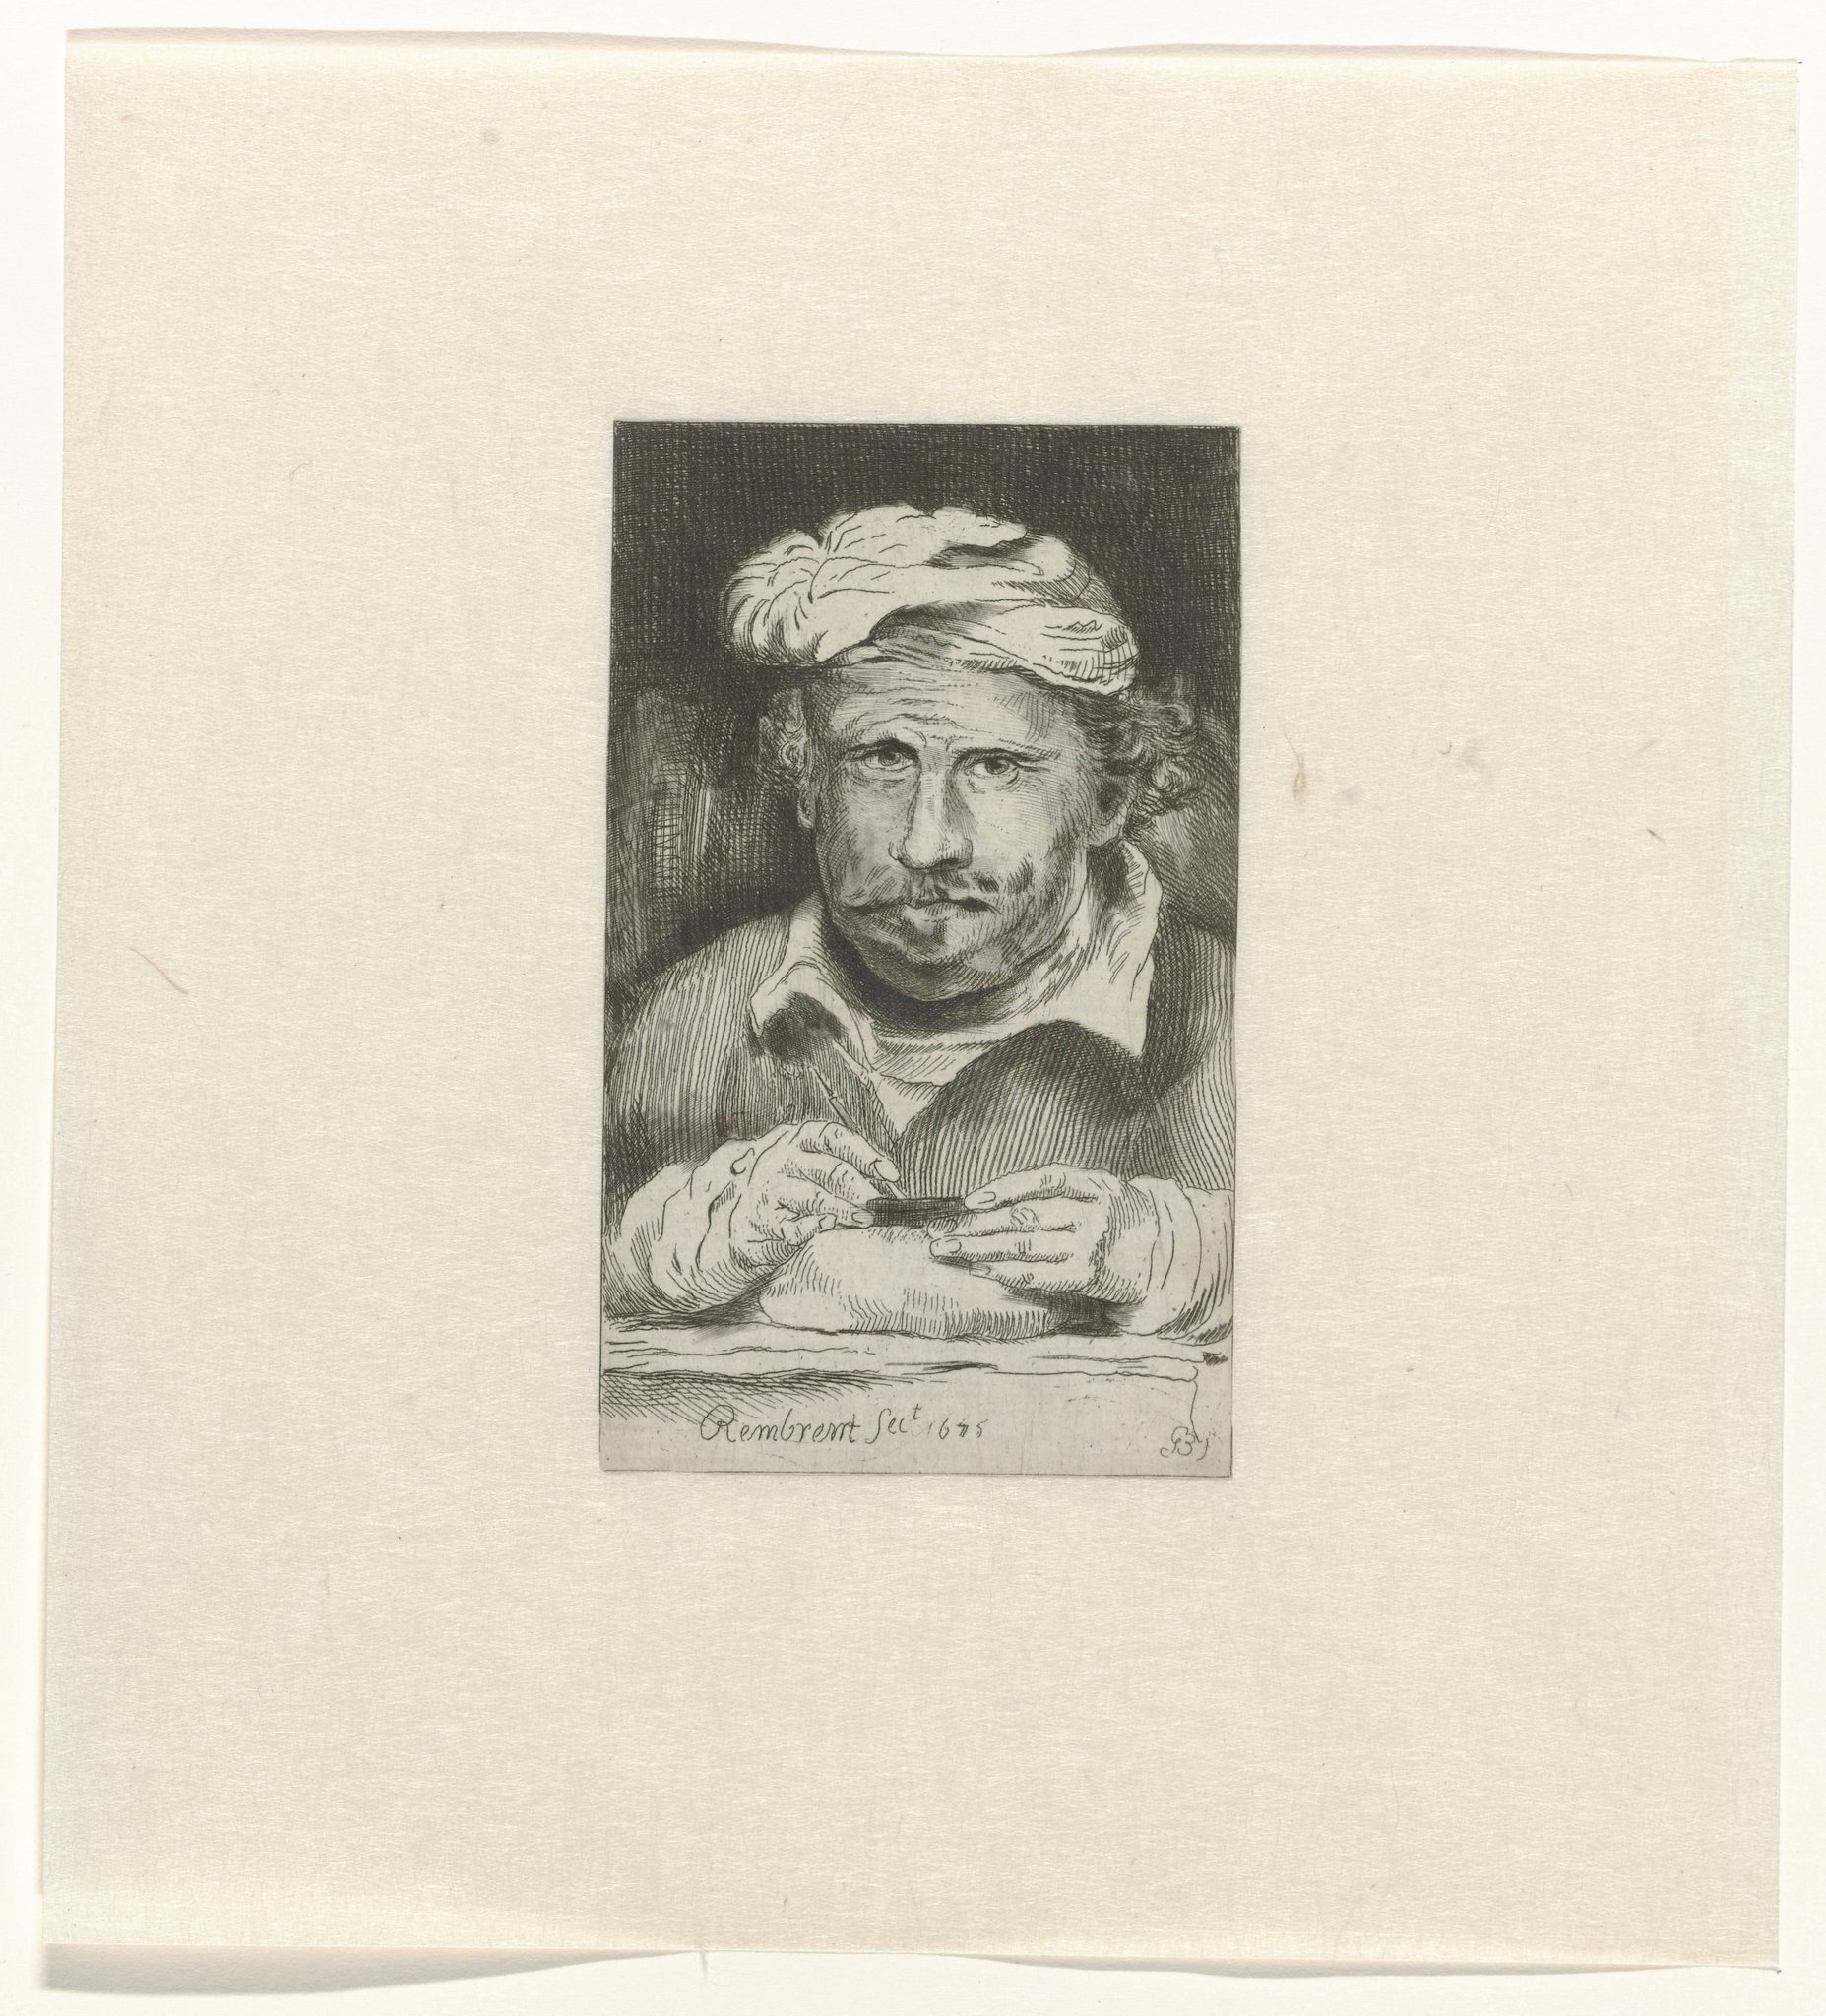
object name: print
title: Self-portrait, drawing on an etching-plate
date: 1800-1899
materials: paper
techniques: etching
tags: leiden, amsterdam, painter, print maker, draughtsman, rembrandt van rijn, tools, implements of graphic artist (+ artist at work), engraver, etcher, portrait, self-portrait of graphic artist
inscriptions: collector's mark: Lugt 2228, collector's mark: Lugt 2760